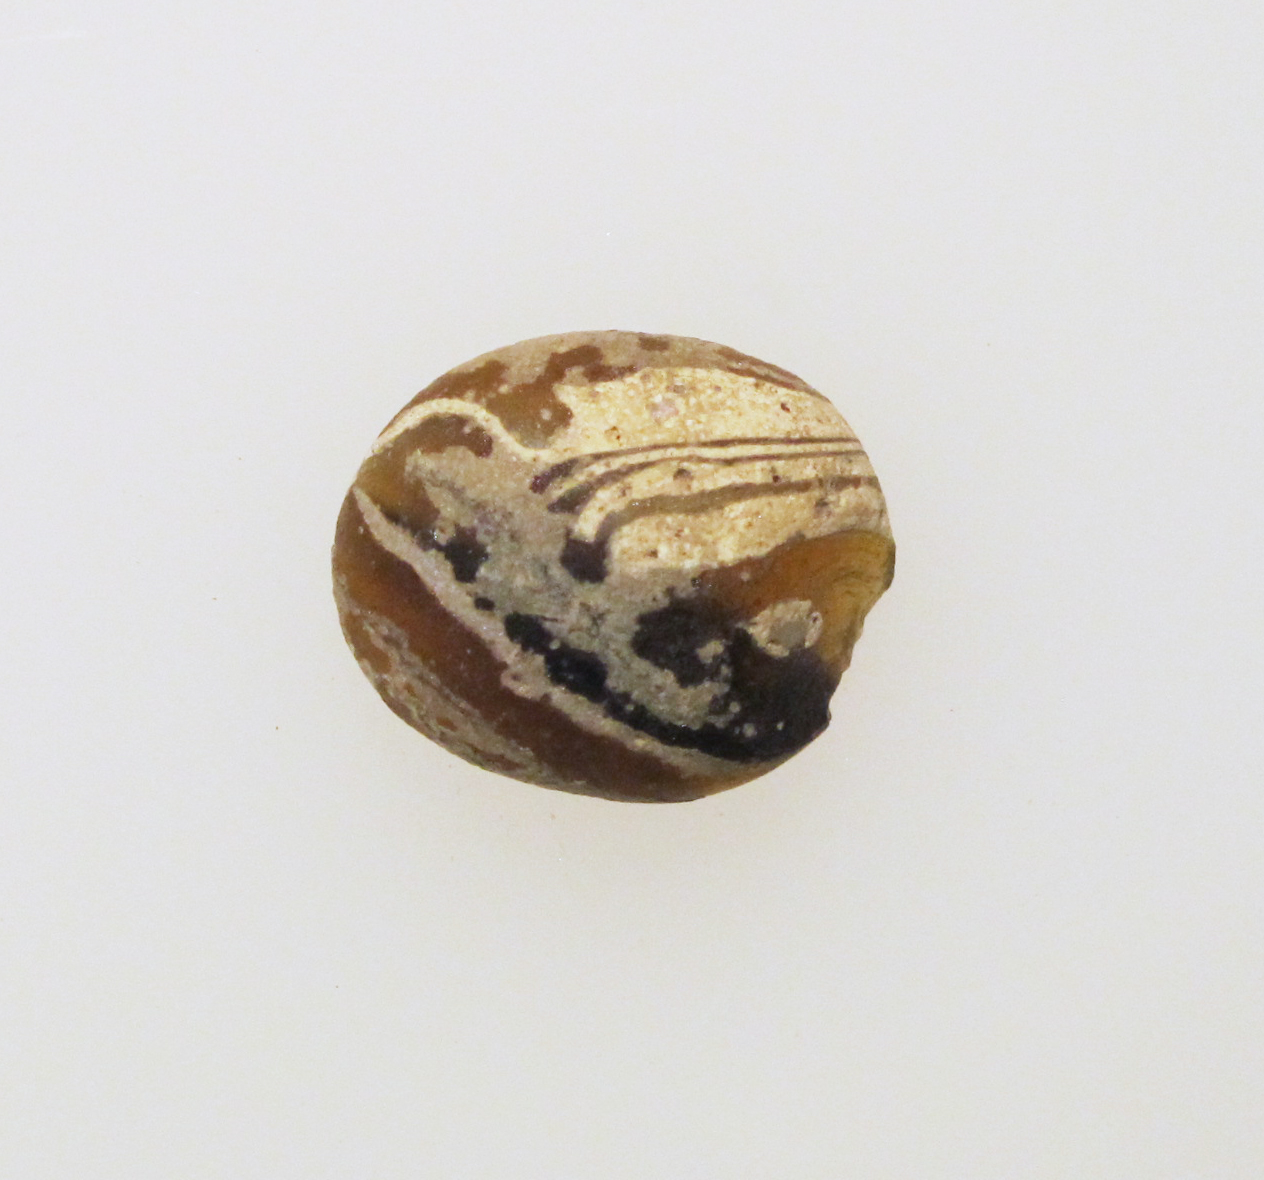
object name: pinhead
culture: roman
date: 670 BCE-330 CE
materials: glass